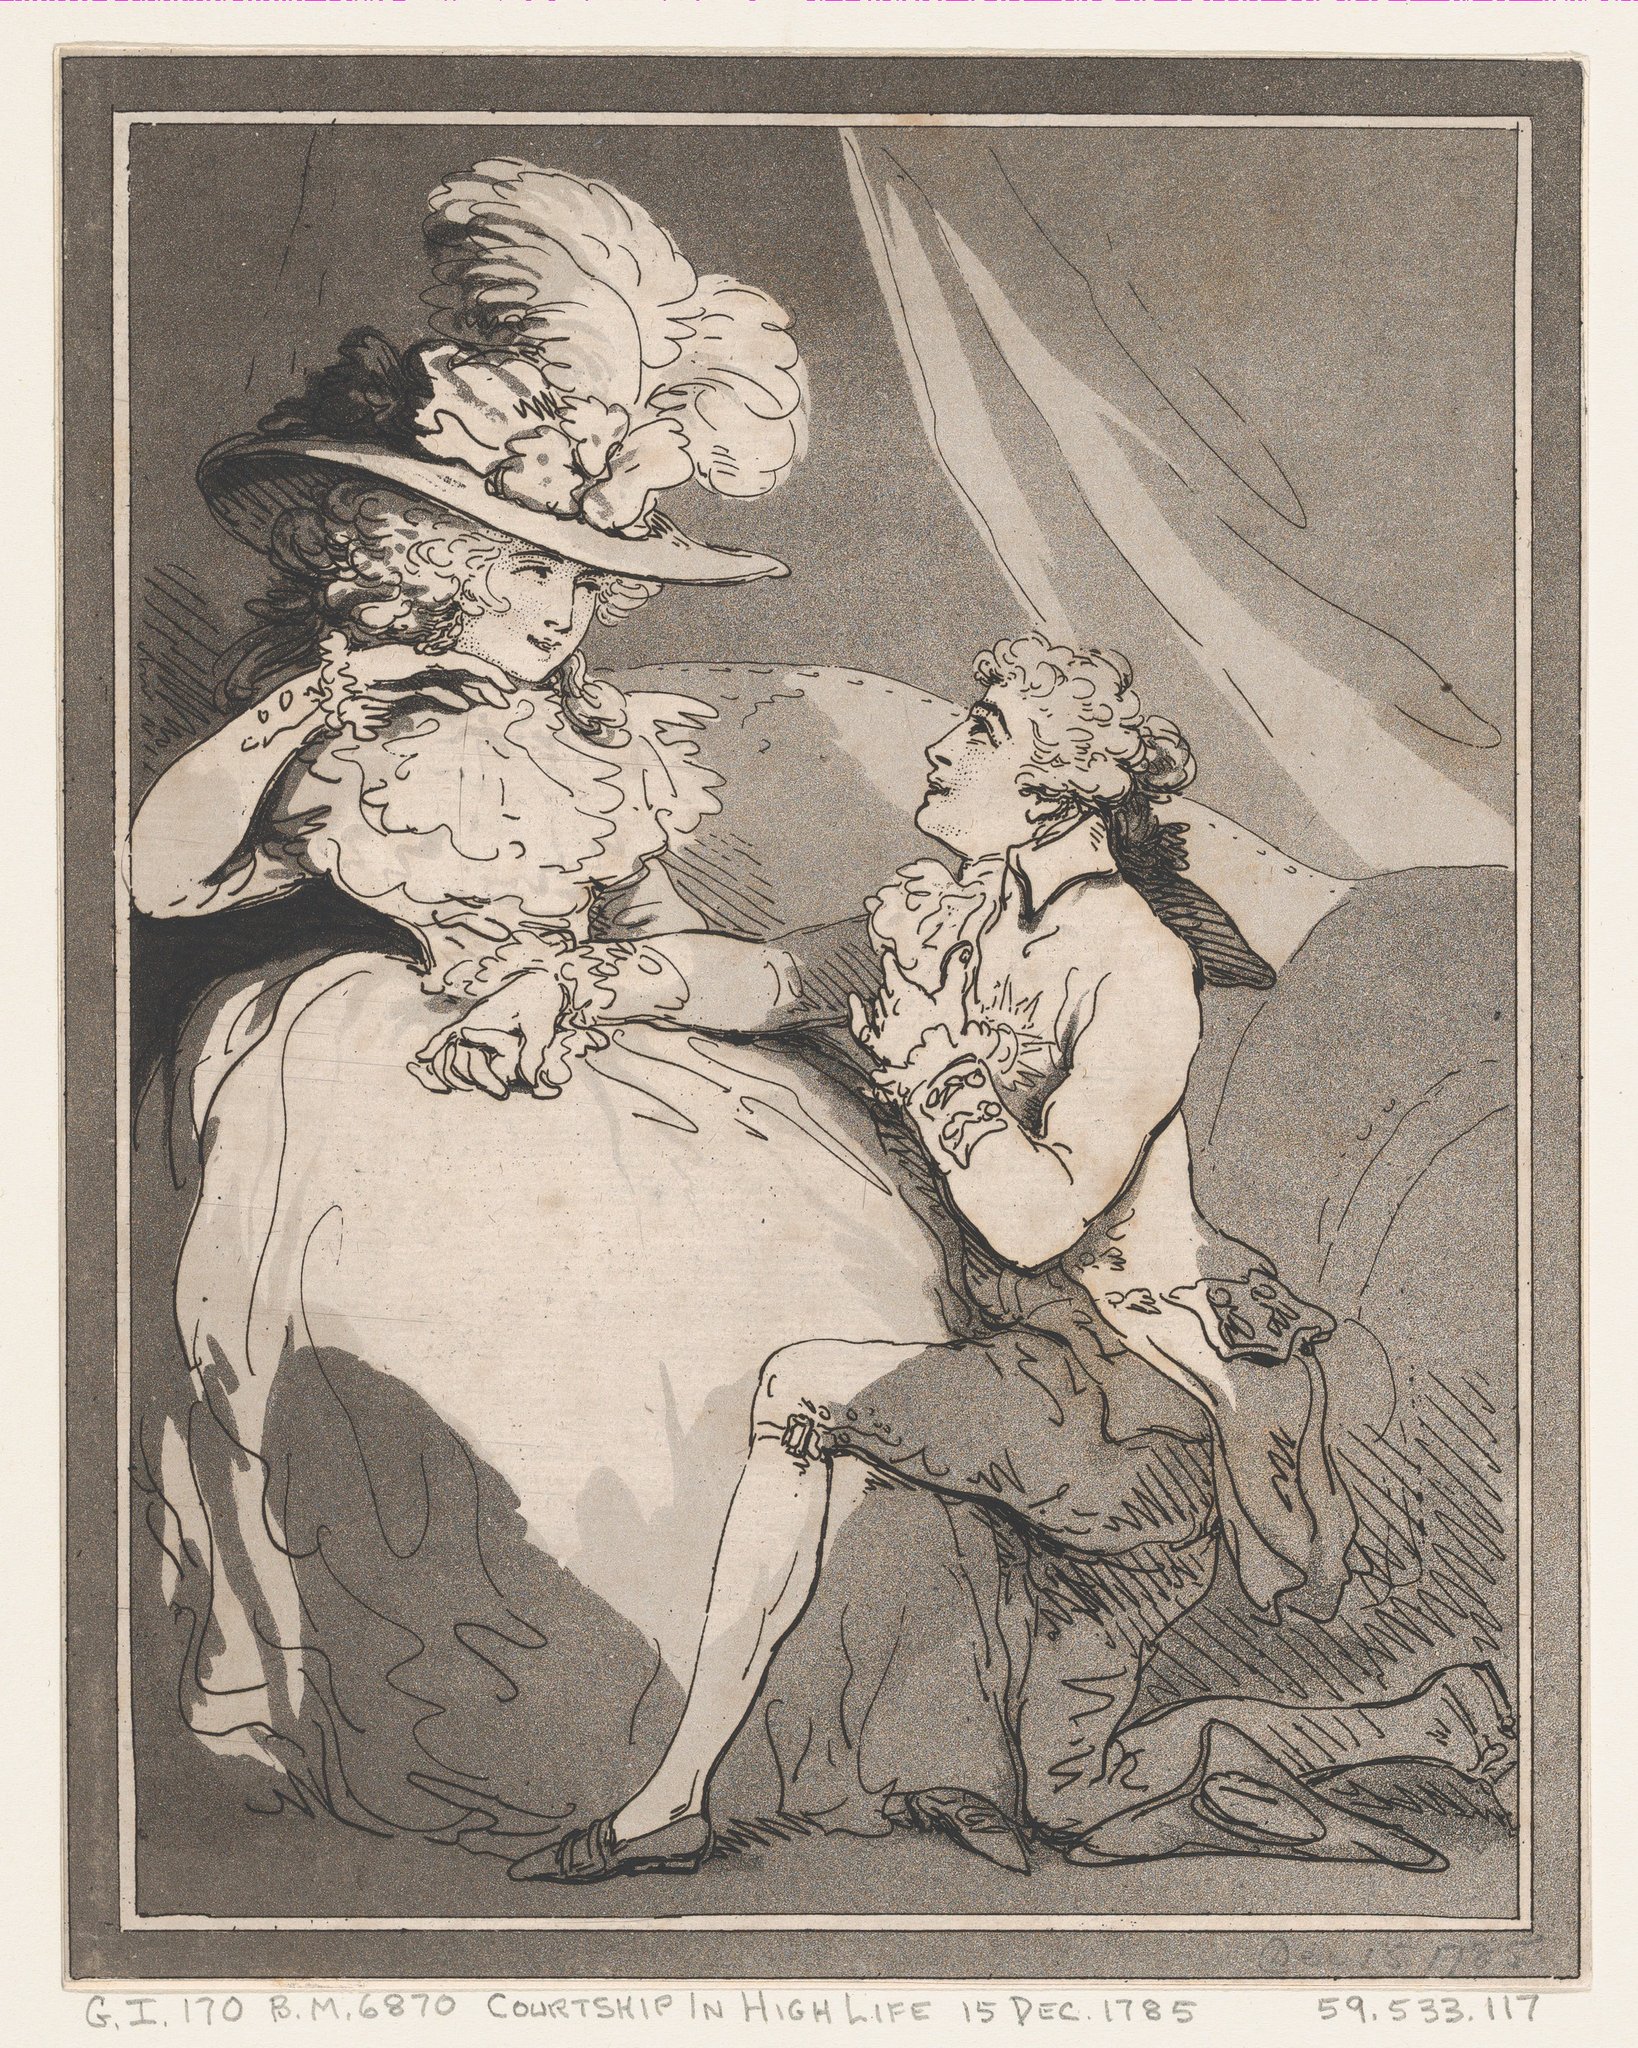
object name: print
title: Courtship in High Life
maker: thomas rowlandson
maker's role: artist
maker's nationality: british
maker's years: 1757-1827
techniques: aquatint, etching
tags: couples,men,women